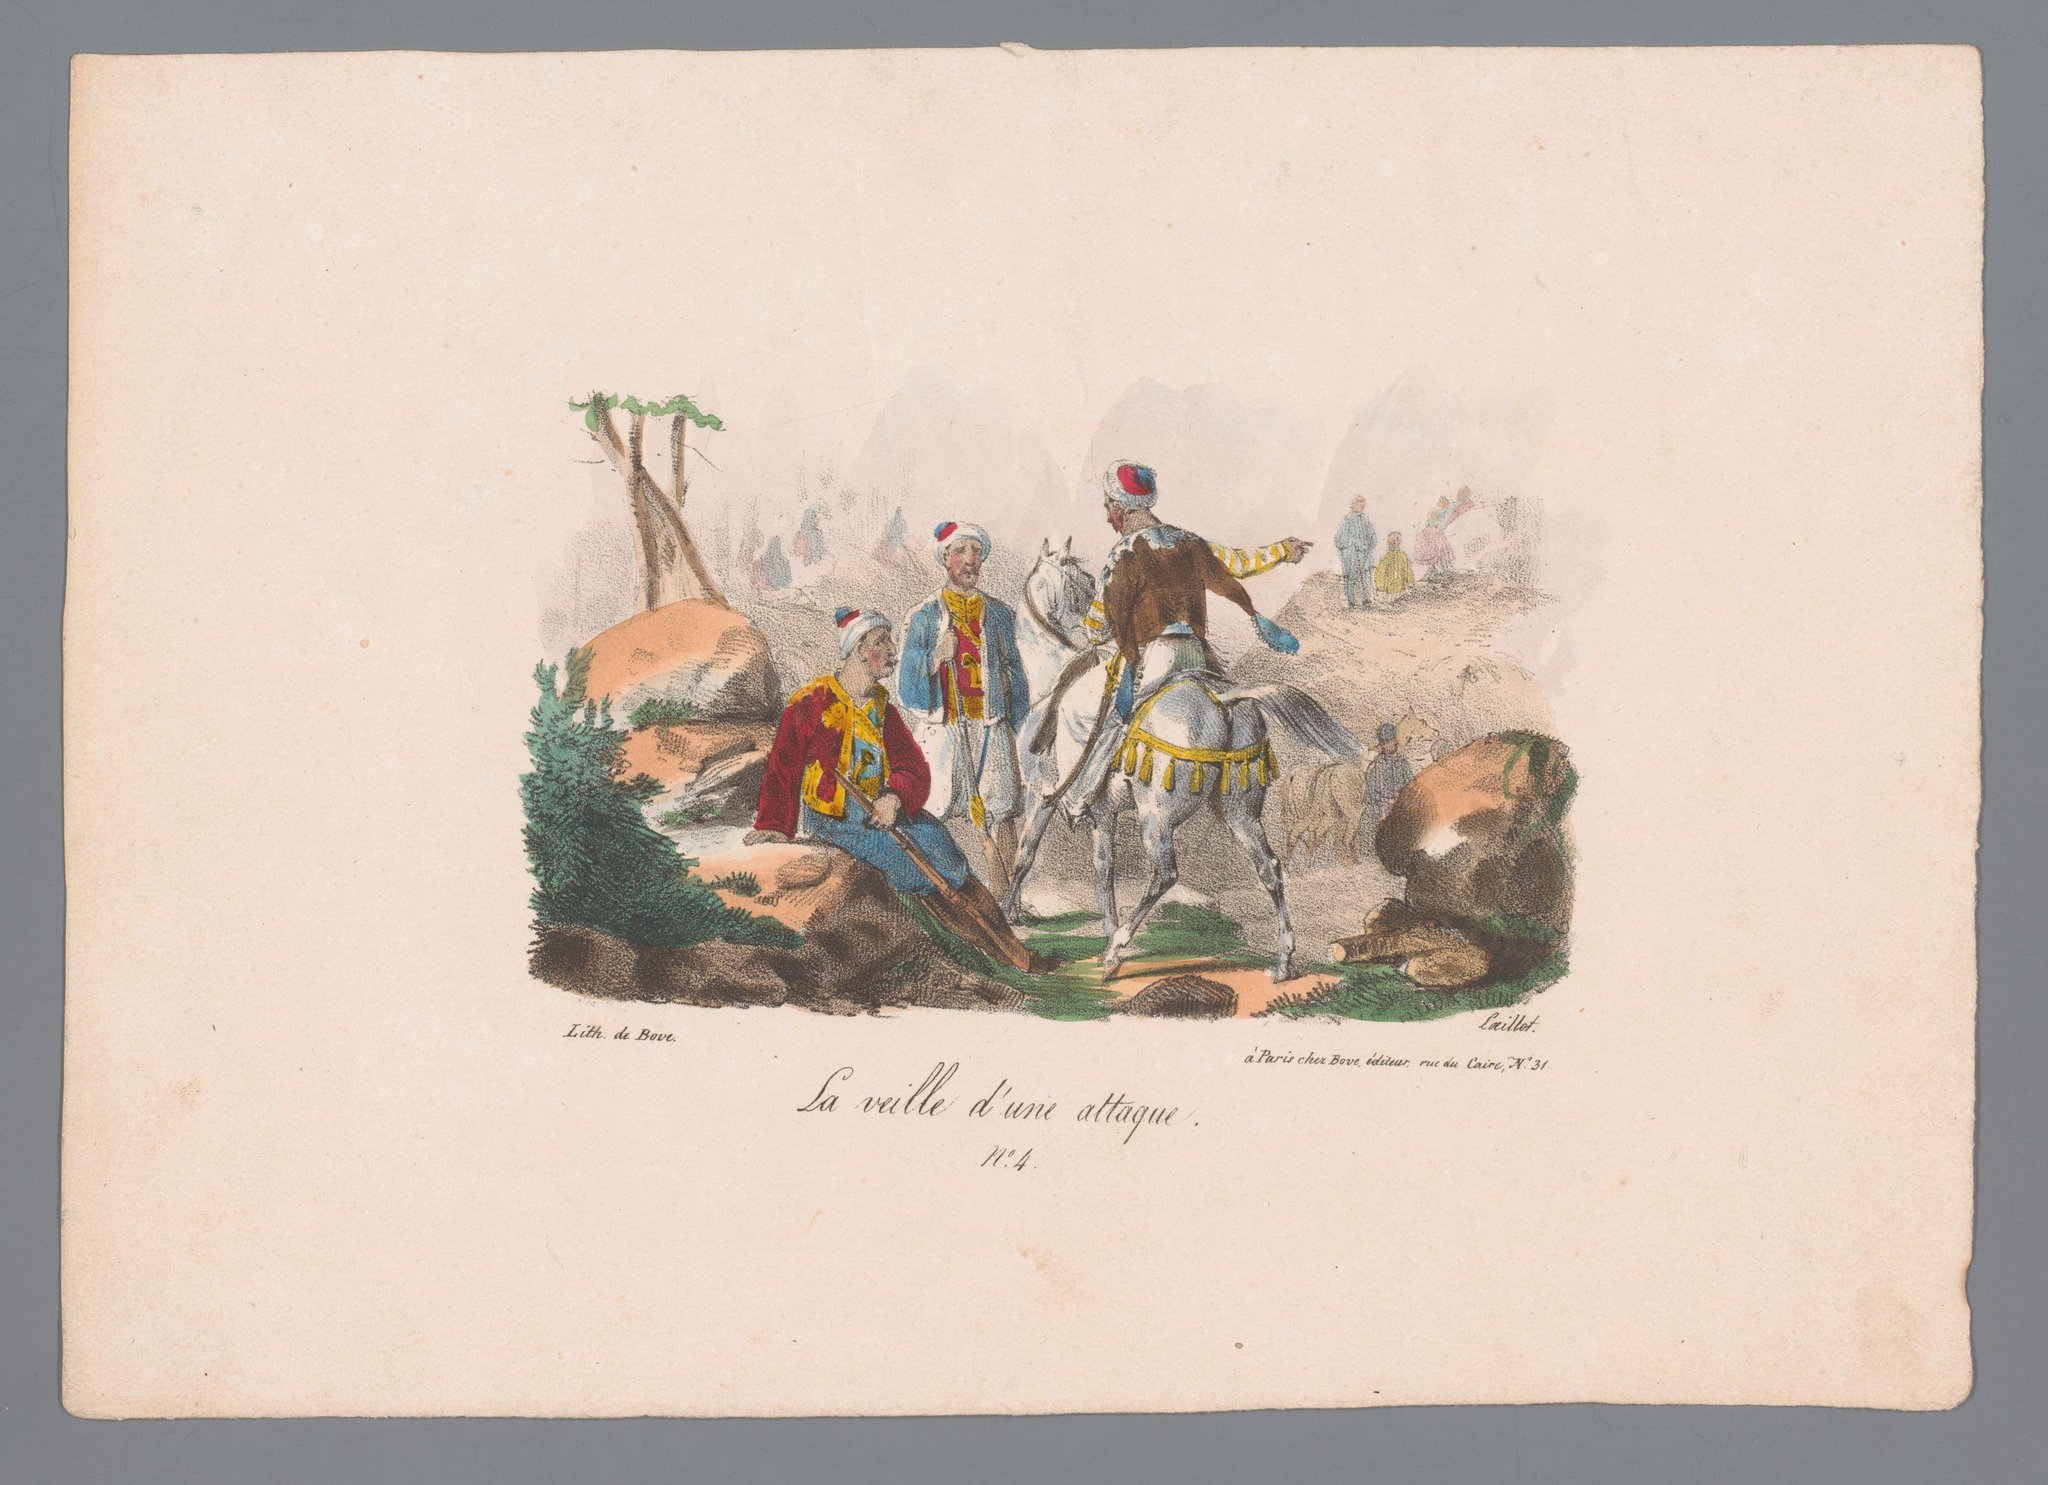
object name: print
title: La veille d'une attaque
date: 1829-1835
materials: paper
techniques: hand coloring, lithograph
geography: paris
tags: riding a horse, ass, or mule; rider, horseman, (military) uniforms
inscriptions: collector's mark: Lugt 2228